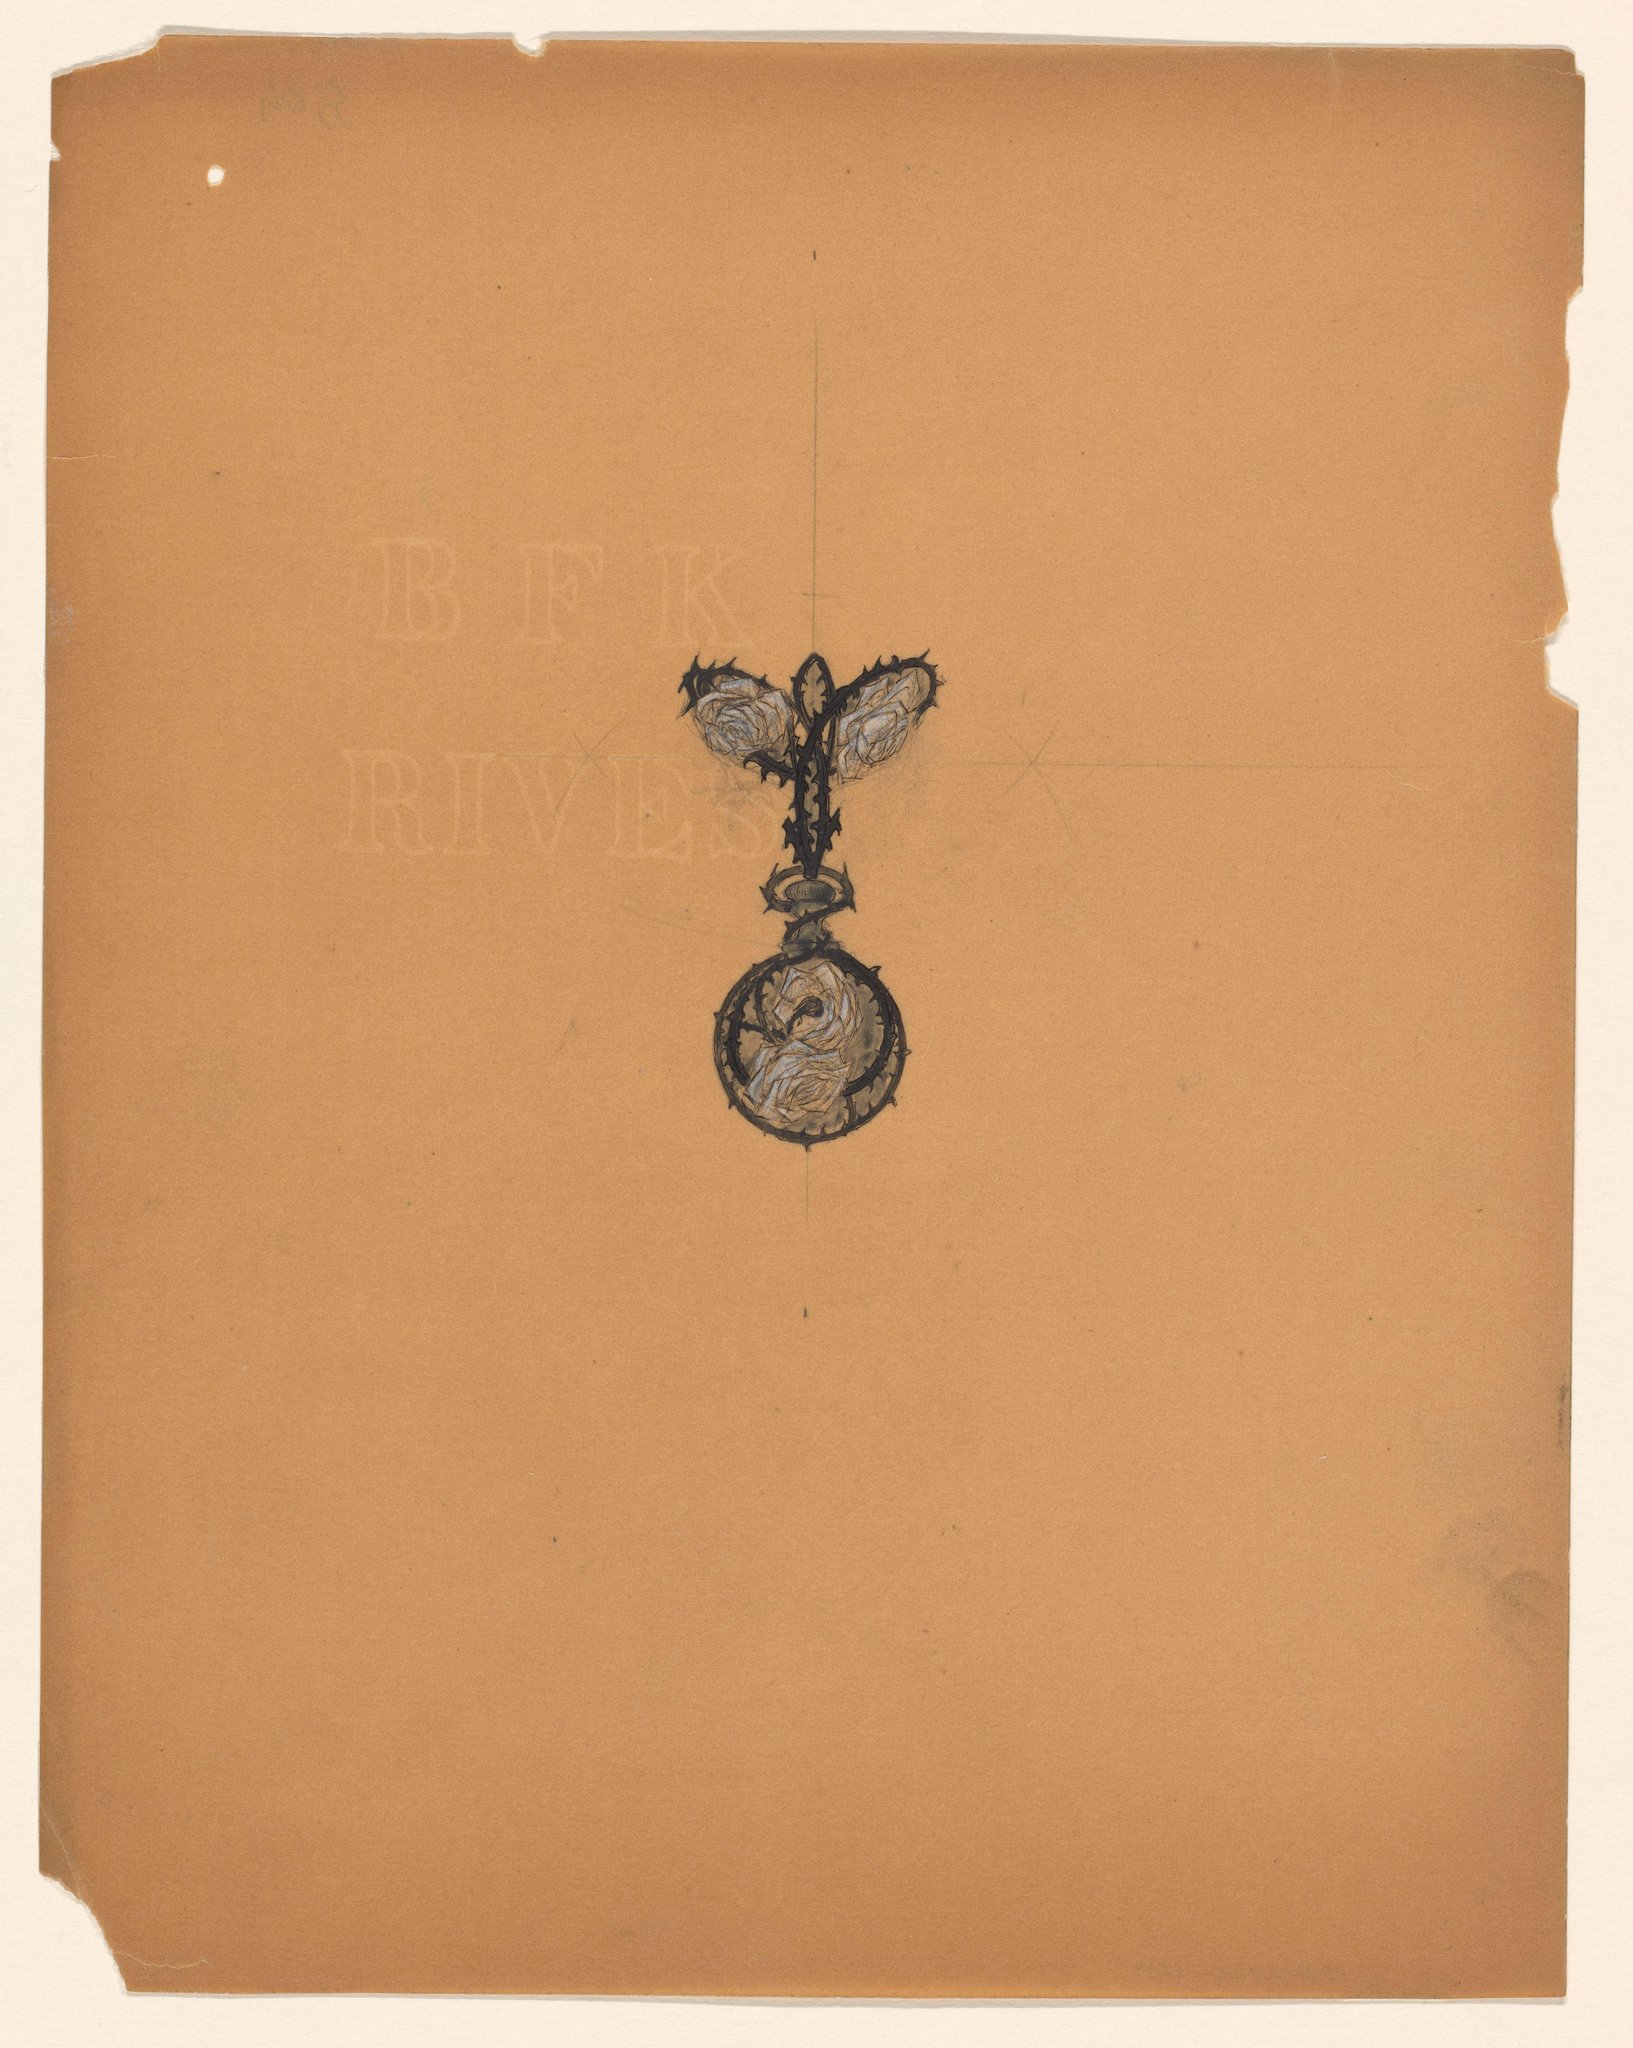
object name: design drawing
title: Design for a Pendant with a Watch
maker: rené lalique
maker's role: jeweler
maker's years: 1860-1945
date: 1900-1904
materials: chalk, graphite, paper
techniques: brush, pen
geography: france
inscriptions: watermark: ‘BFK / RIVES’, number: ‘408 [?]’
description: The roses in this pendant were to be made of glass, set in gold with black enamel. After 1906 Lalique would concentrate solely on the production of glass objects.